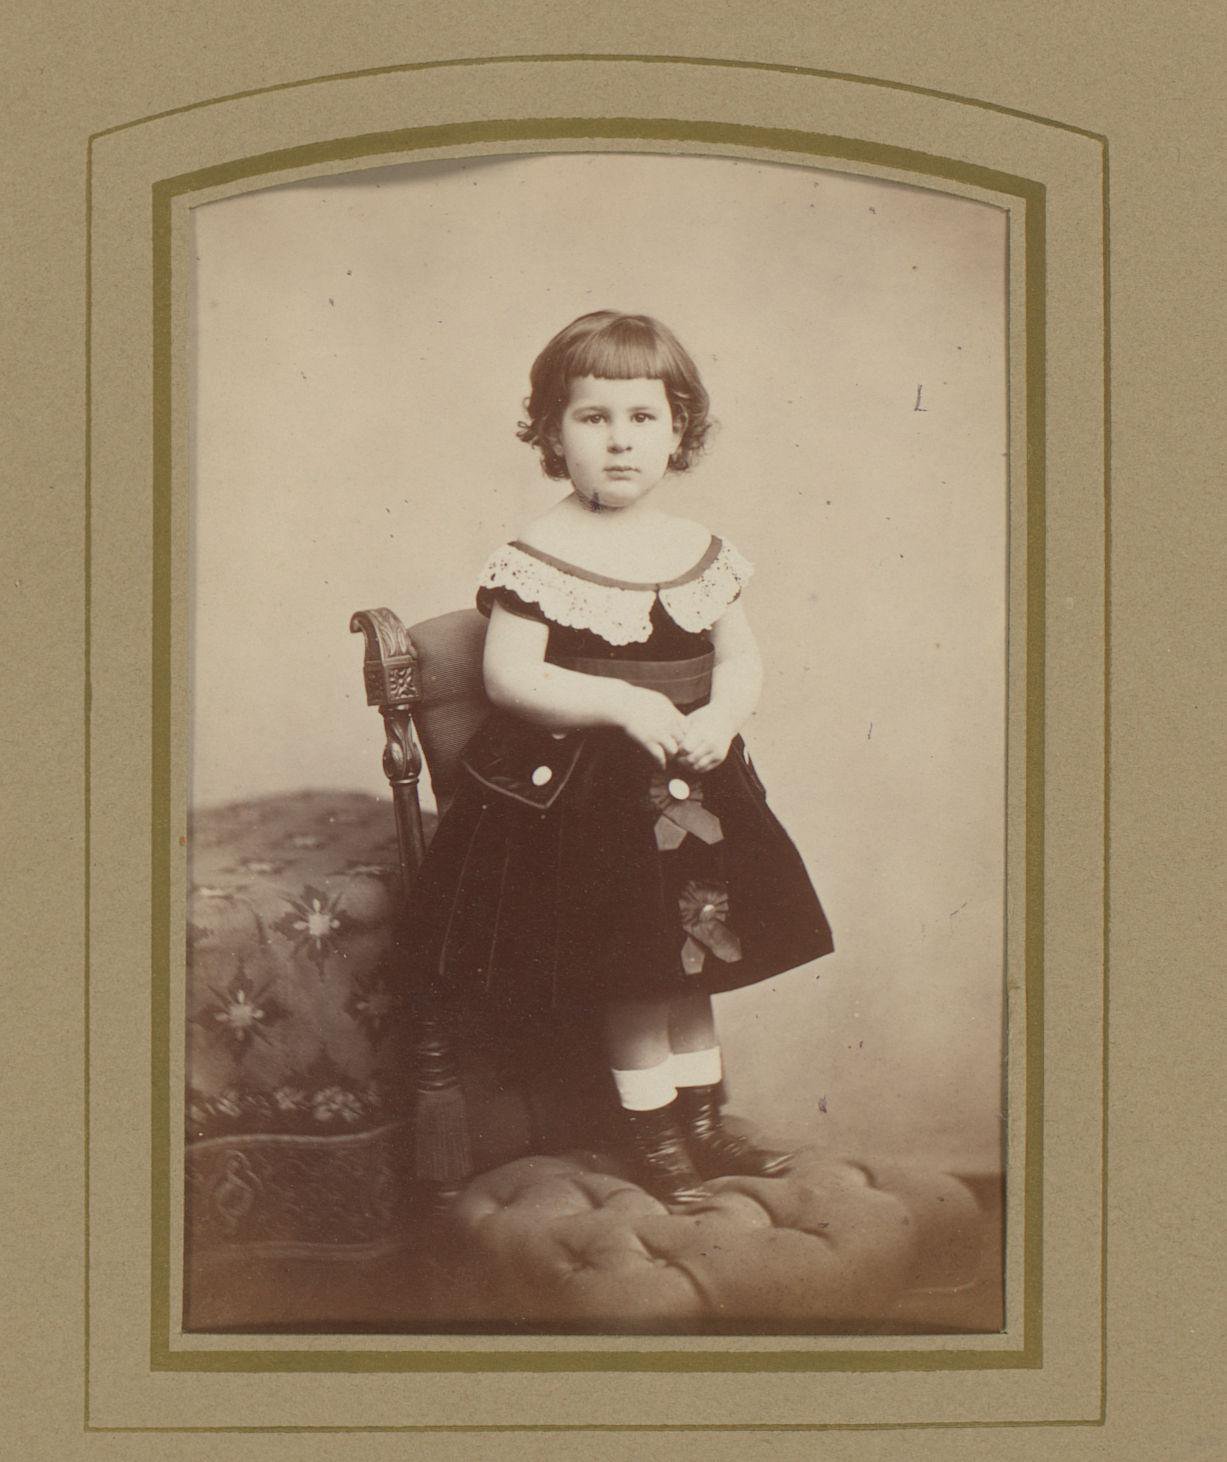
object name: photograph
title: Portret van een meisje, staand op een stoel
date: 1875-1900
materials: cardboard, photographic support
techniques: albumen print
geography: netherlands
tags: historical persons - bb - woman, girl (child between toddler and youth), chair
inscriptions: inscription: ‘Wegner & Mottu/ Photographisch Artistisch Atelier/ AMSTERDAM/ Rokin . D 88.’